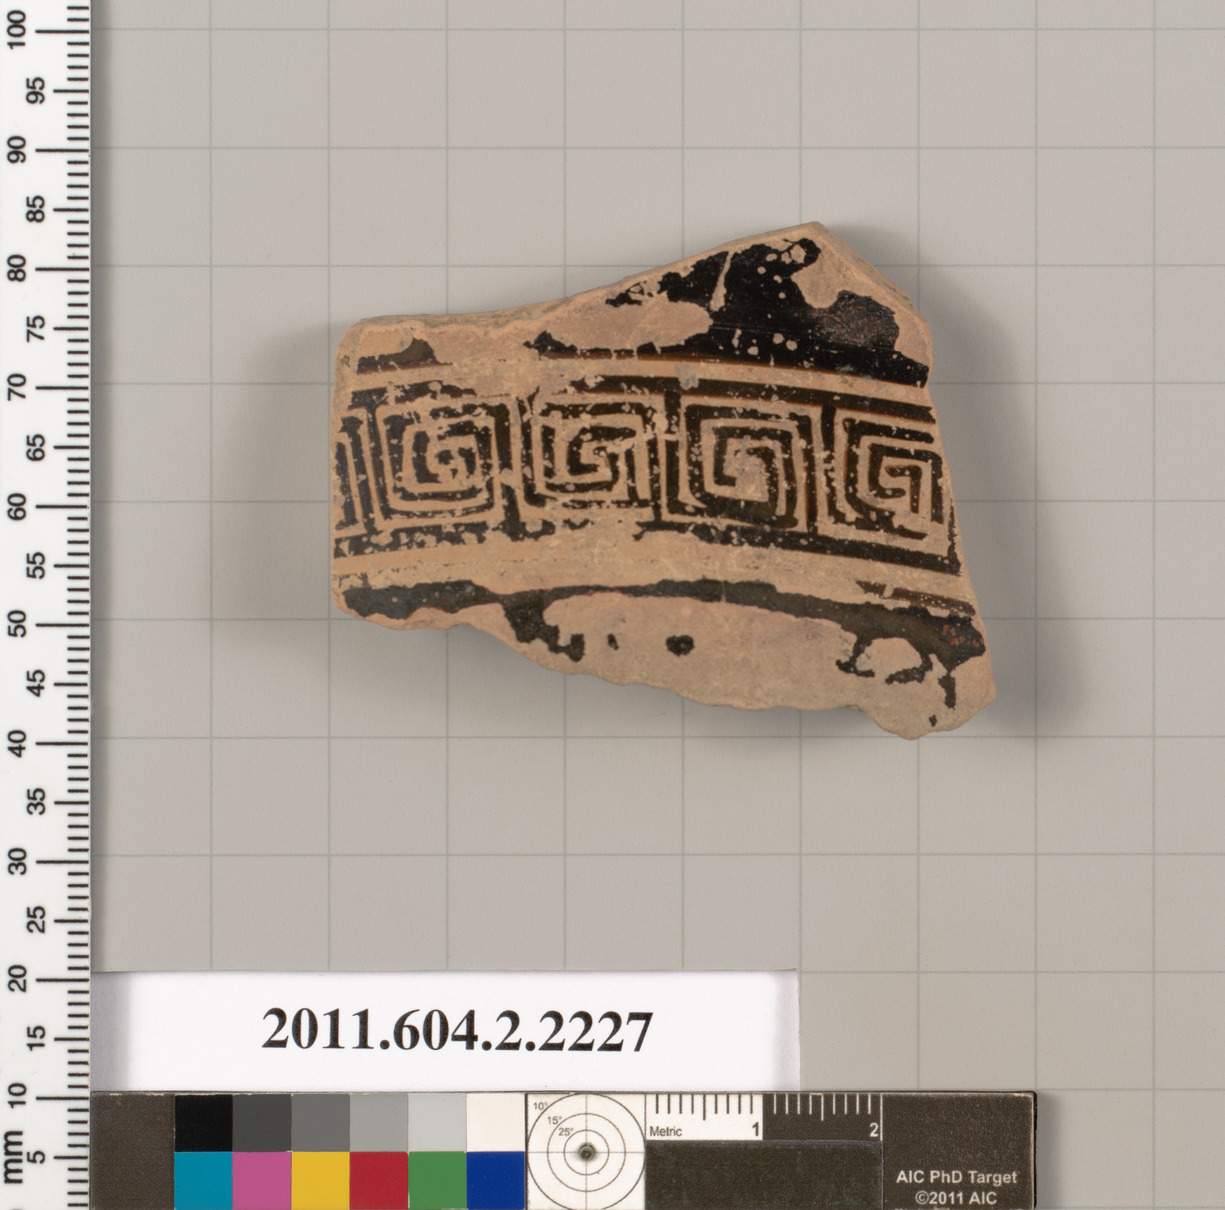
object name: pot fragment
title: Terracotta fragment of a pot; unglazed on the inside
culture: greek, attic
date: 475-451 BCE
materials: terracotta